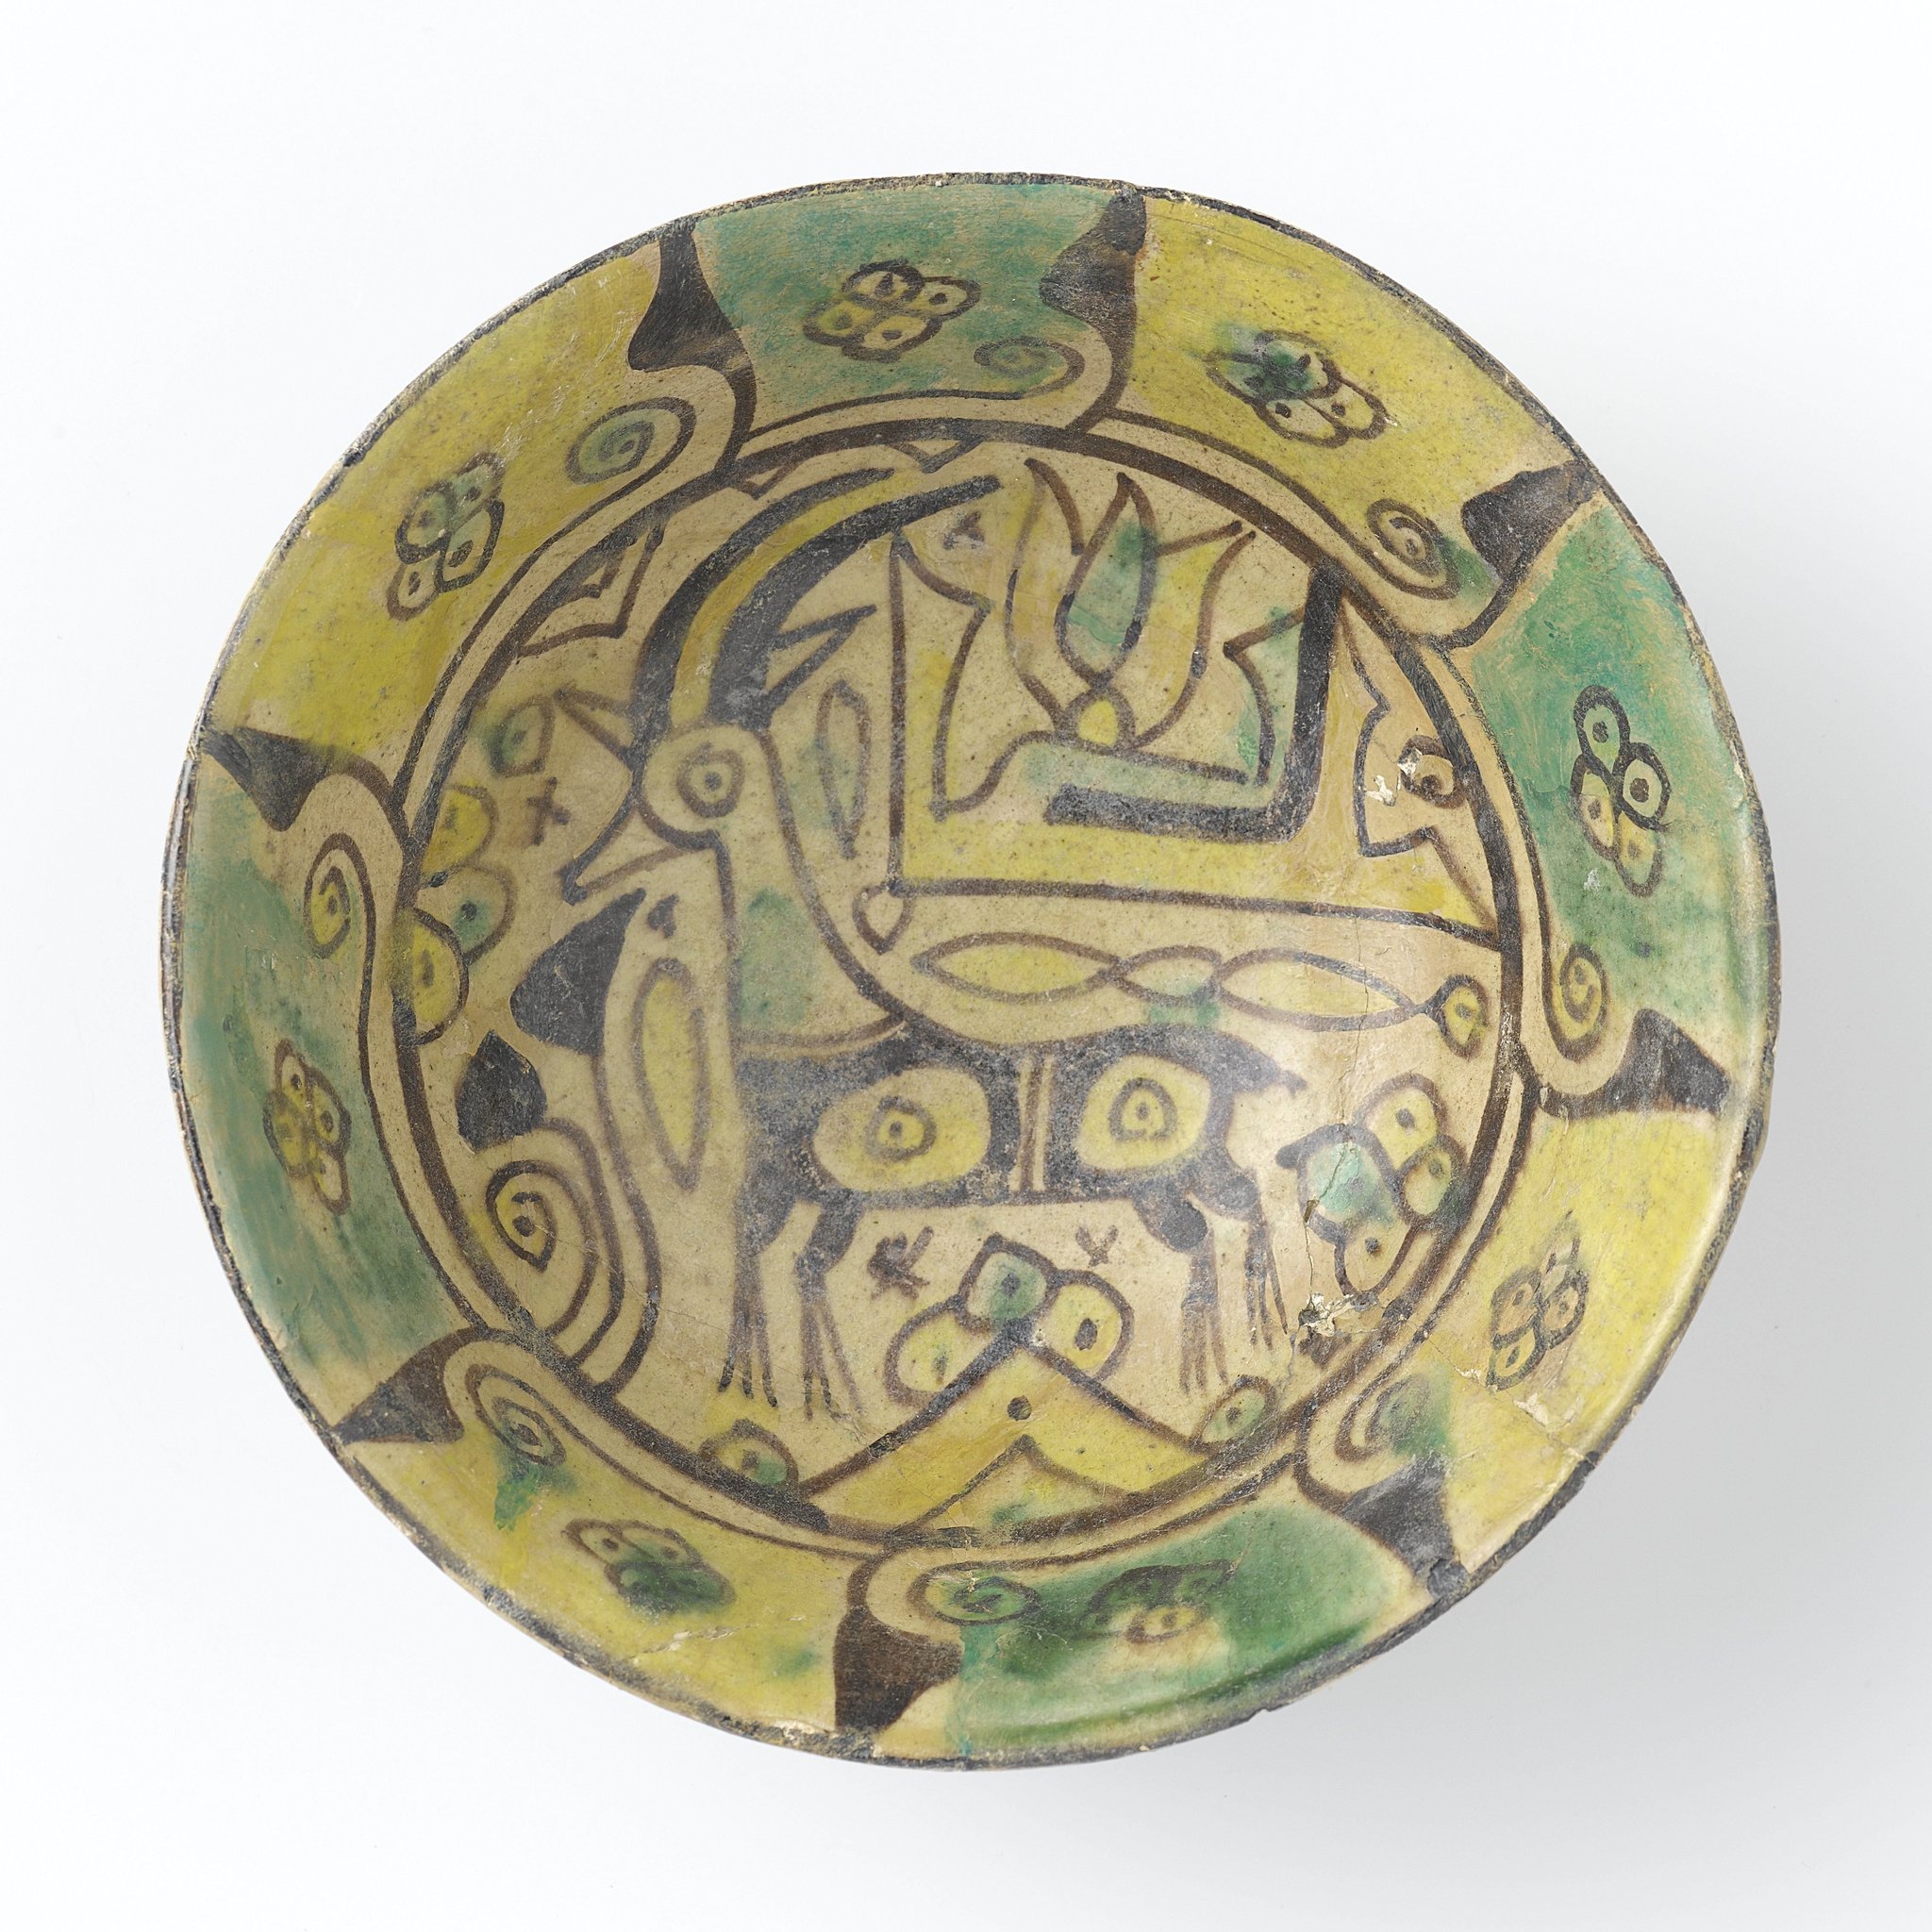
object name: bowl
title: Bowl with a goat in the center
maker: Anonymous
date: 900-999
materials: earthenware, glaze, paint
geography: nishapur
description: Kom met een rechte wand, gedecoreerd in polychroom slib. In het plat een bok, op de binnenwand velden met een gestileerde bloem en op de buitenwand verticale lijnen en gekleurde ovalen. (gebroken en gelijmd)